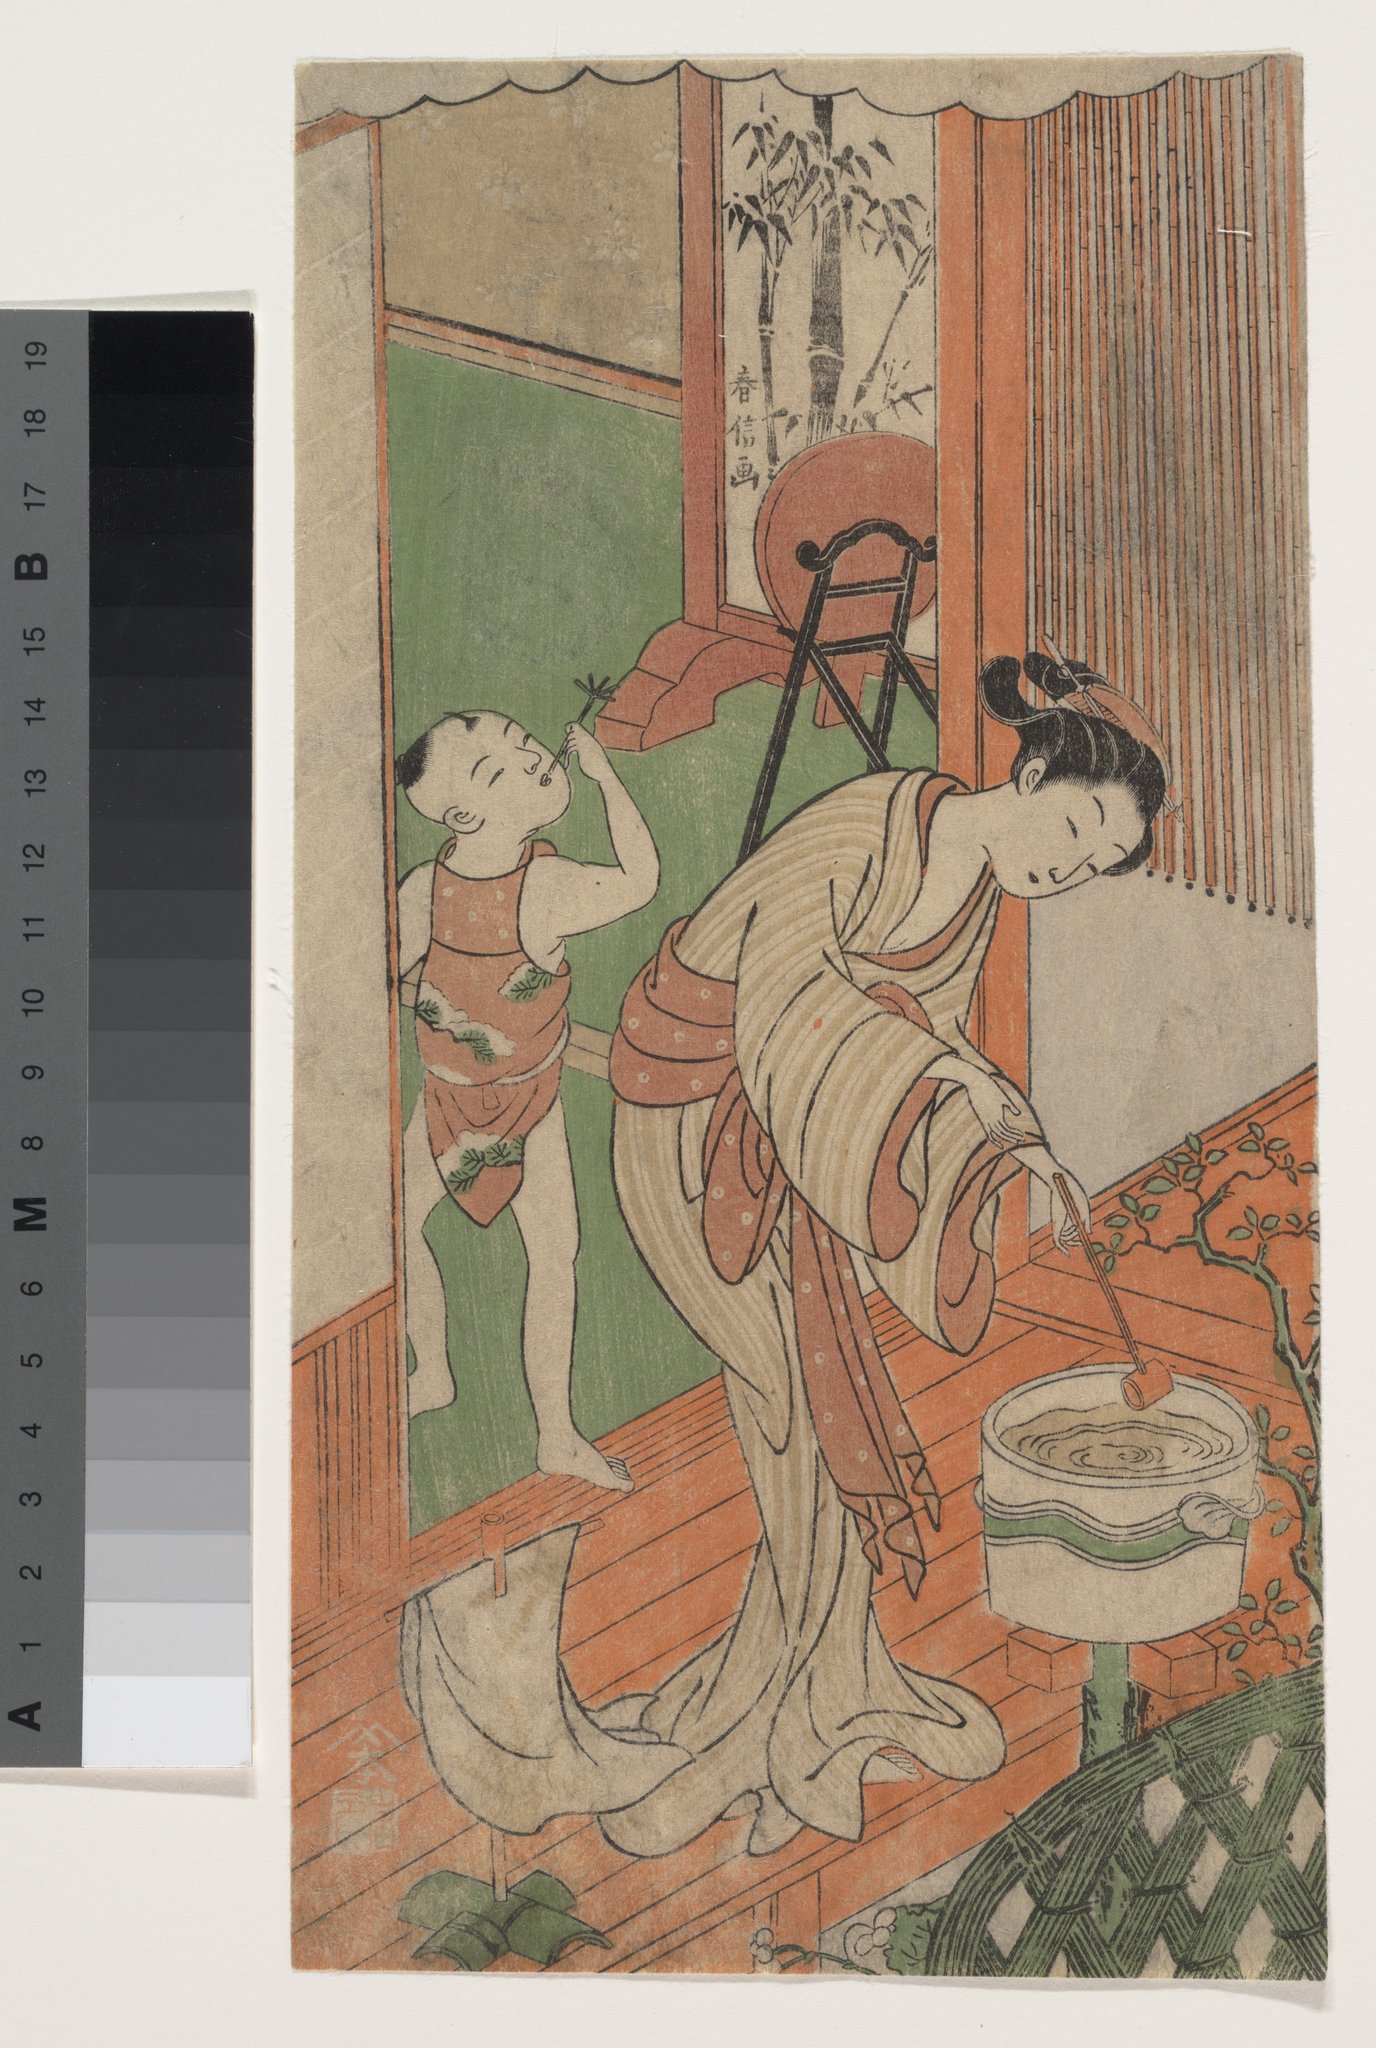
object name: print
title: On the Veranda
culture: japanese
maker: suzuki harunobu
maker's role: artist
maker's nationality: japanese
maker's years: 1725-1770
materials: ink, paper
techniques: woodblock print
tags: boys,women,genre scene